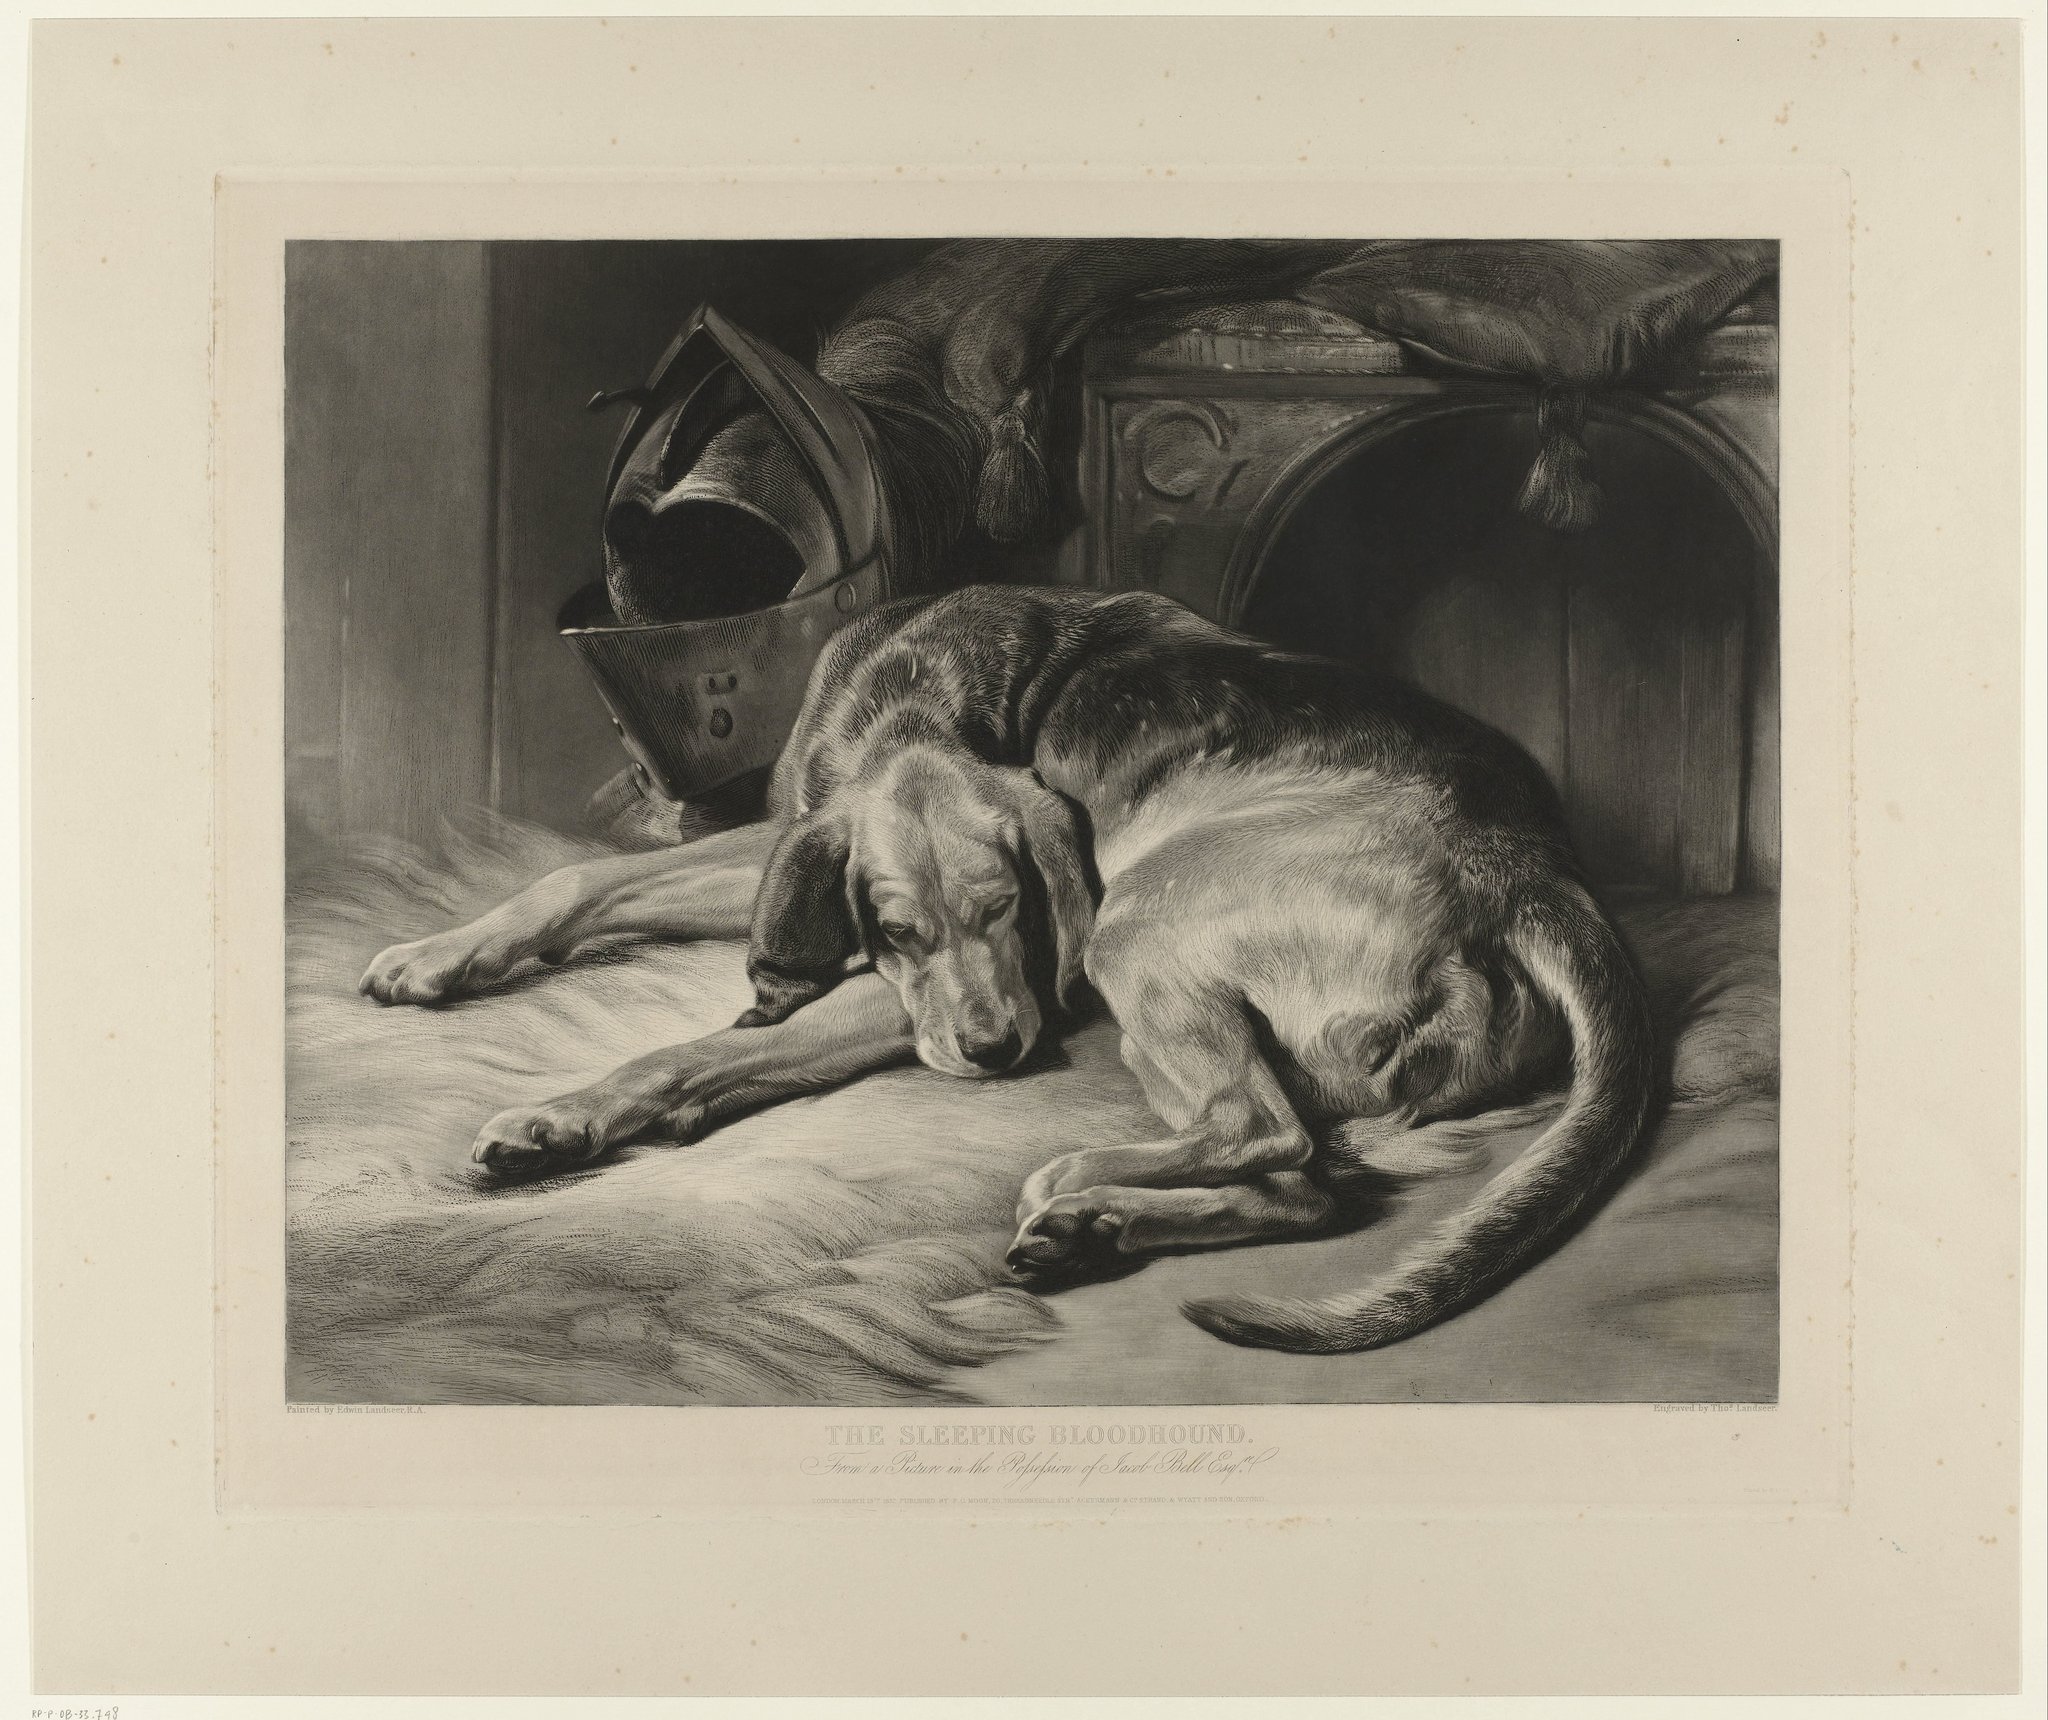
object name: print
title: Slapende jachthond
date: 1837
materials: paper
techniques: aquatint, engraving, etching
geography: london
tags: helmet, animals (+ sleeping animal(s)), dog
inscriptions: collector's mark: Lugt 12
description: De hond is waarschijnlijk een braque français.